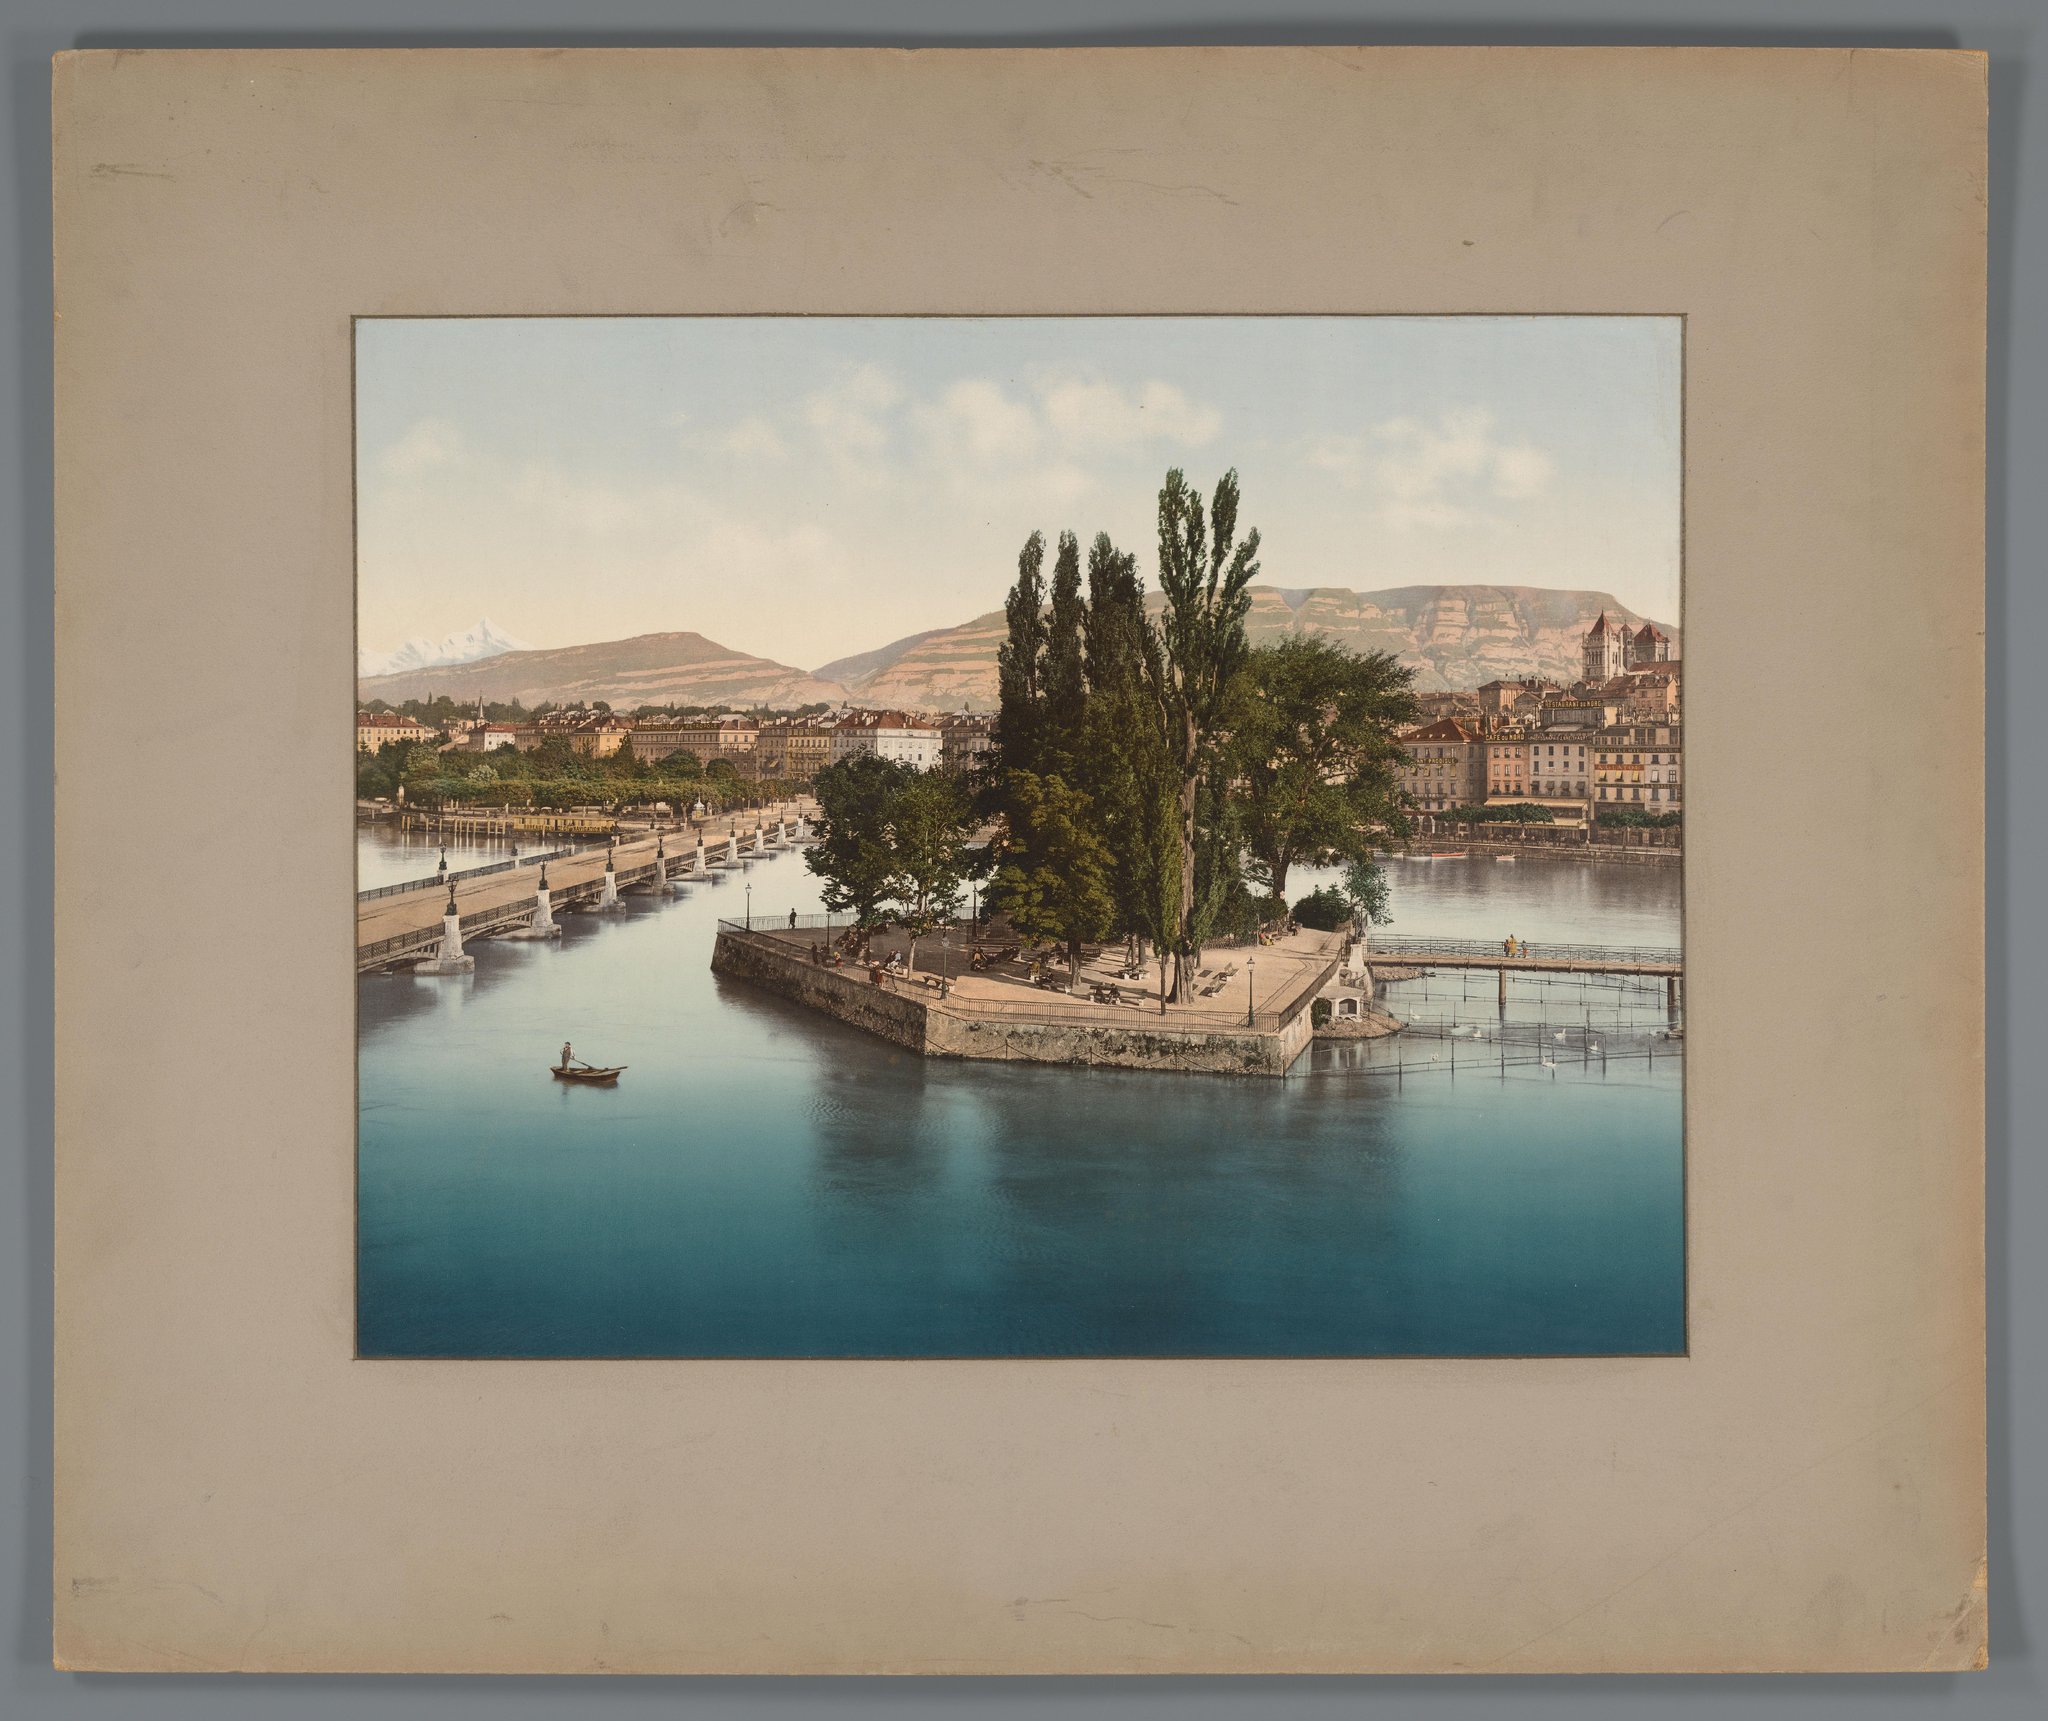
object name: photomechanical print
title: Gezicht op het Île Rousseau te Genève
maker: Anonymous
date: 1890-1920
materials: paper, photographic process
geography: geneva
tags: island, city-view in general; 'veduta'